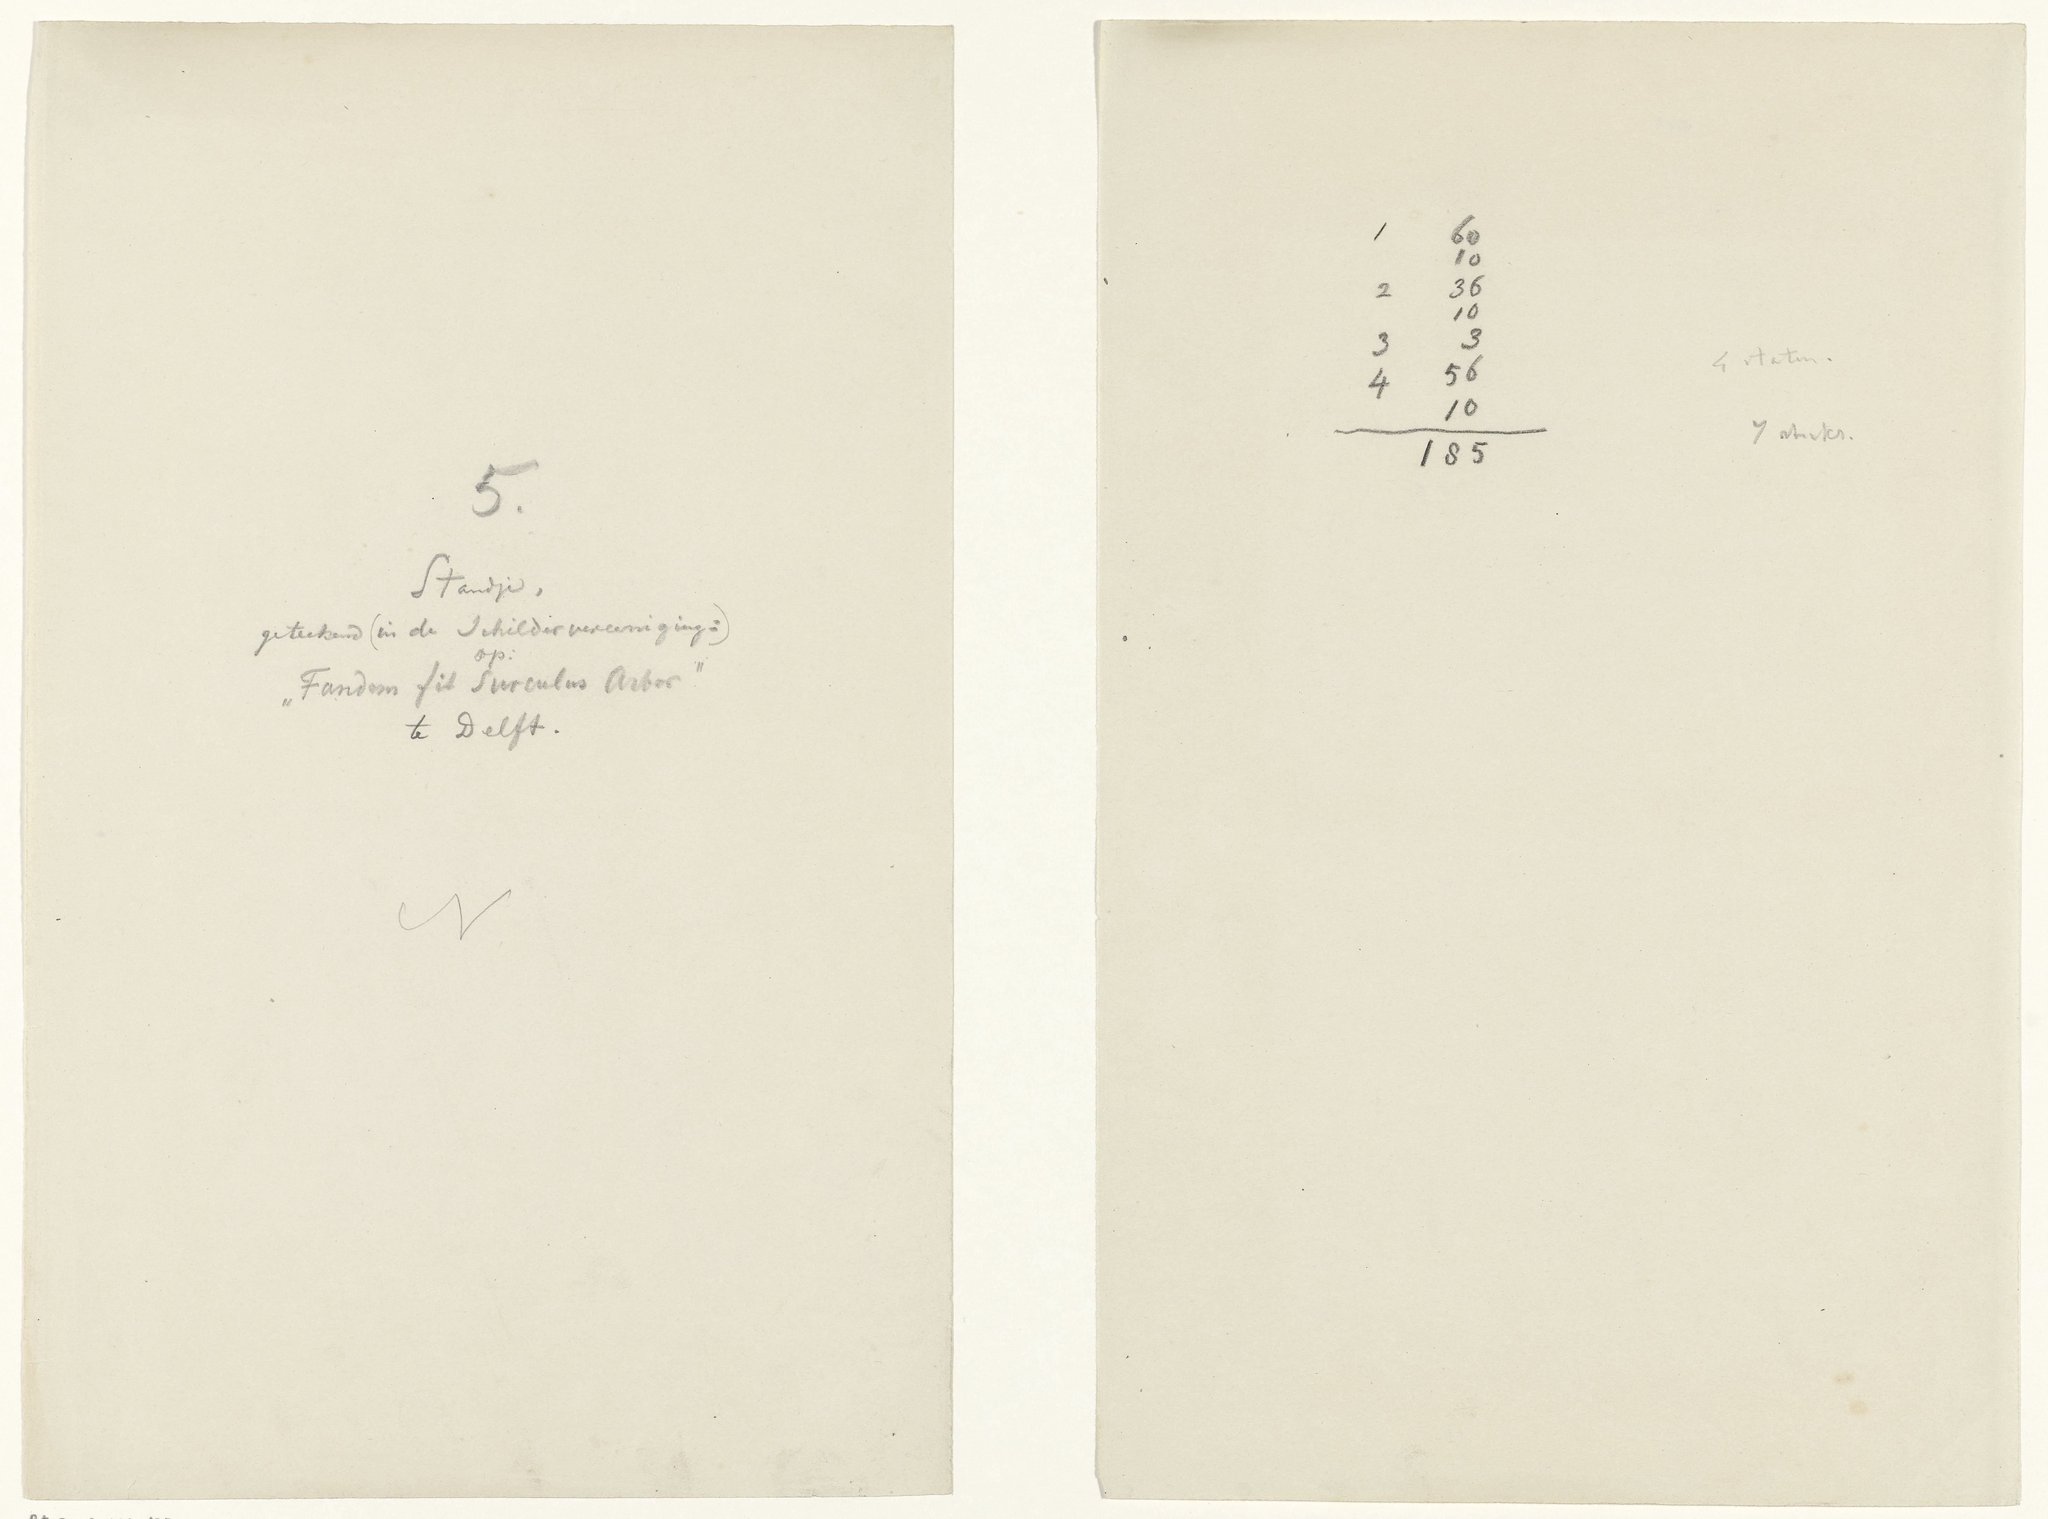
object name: wrapper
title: Omslag voor de verschillende staten van de prent 'Figuurstudie van een onbekende man' door Cornelis van der Grient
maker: cornelis van der griendt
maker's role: draughtsman, painter, print maker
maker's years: 1827-1918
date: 1857-1918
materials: paper, pencil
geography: netherlands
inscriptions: inscription: ‘[...] 185, 4 staten 7 staten’